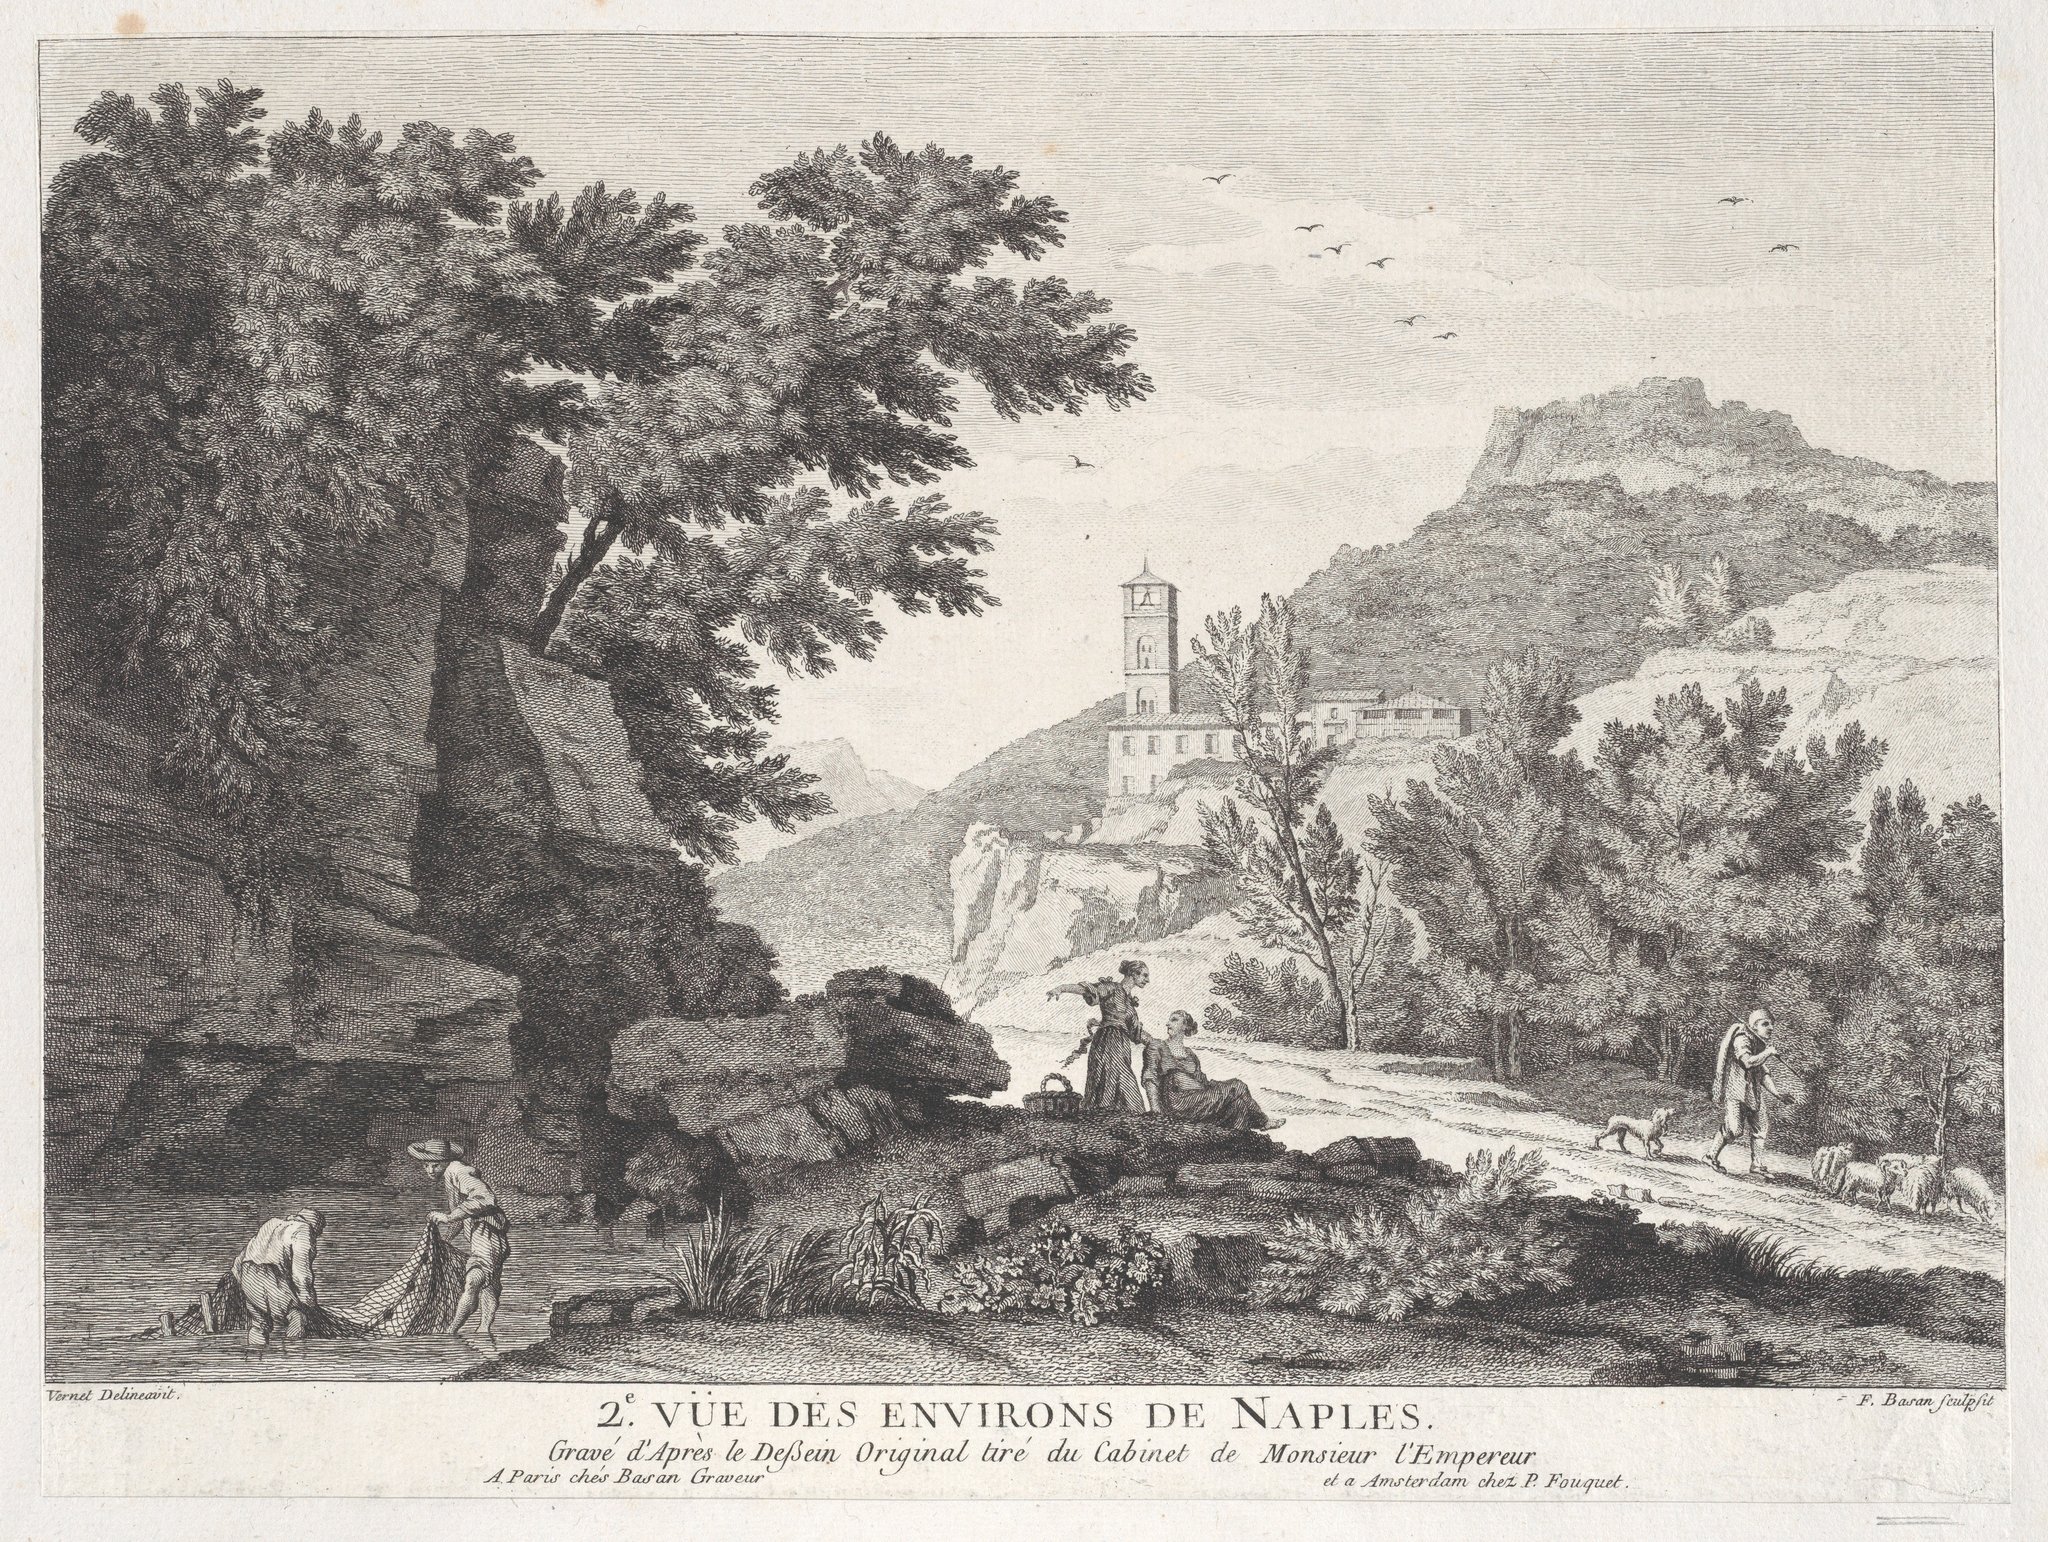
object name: print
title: Deuxieme Vue des Environs de Naples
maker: pierre françois basan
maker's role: engraver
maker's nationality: french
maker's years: 1723-1797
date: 1765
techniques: engraving